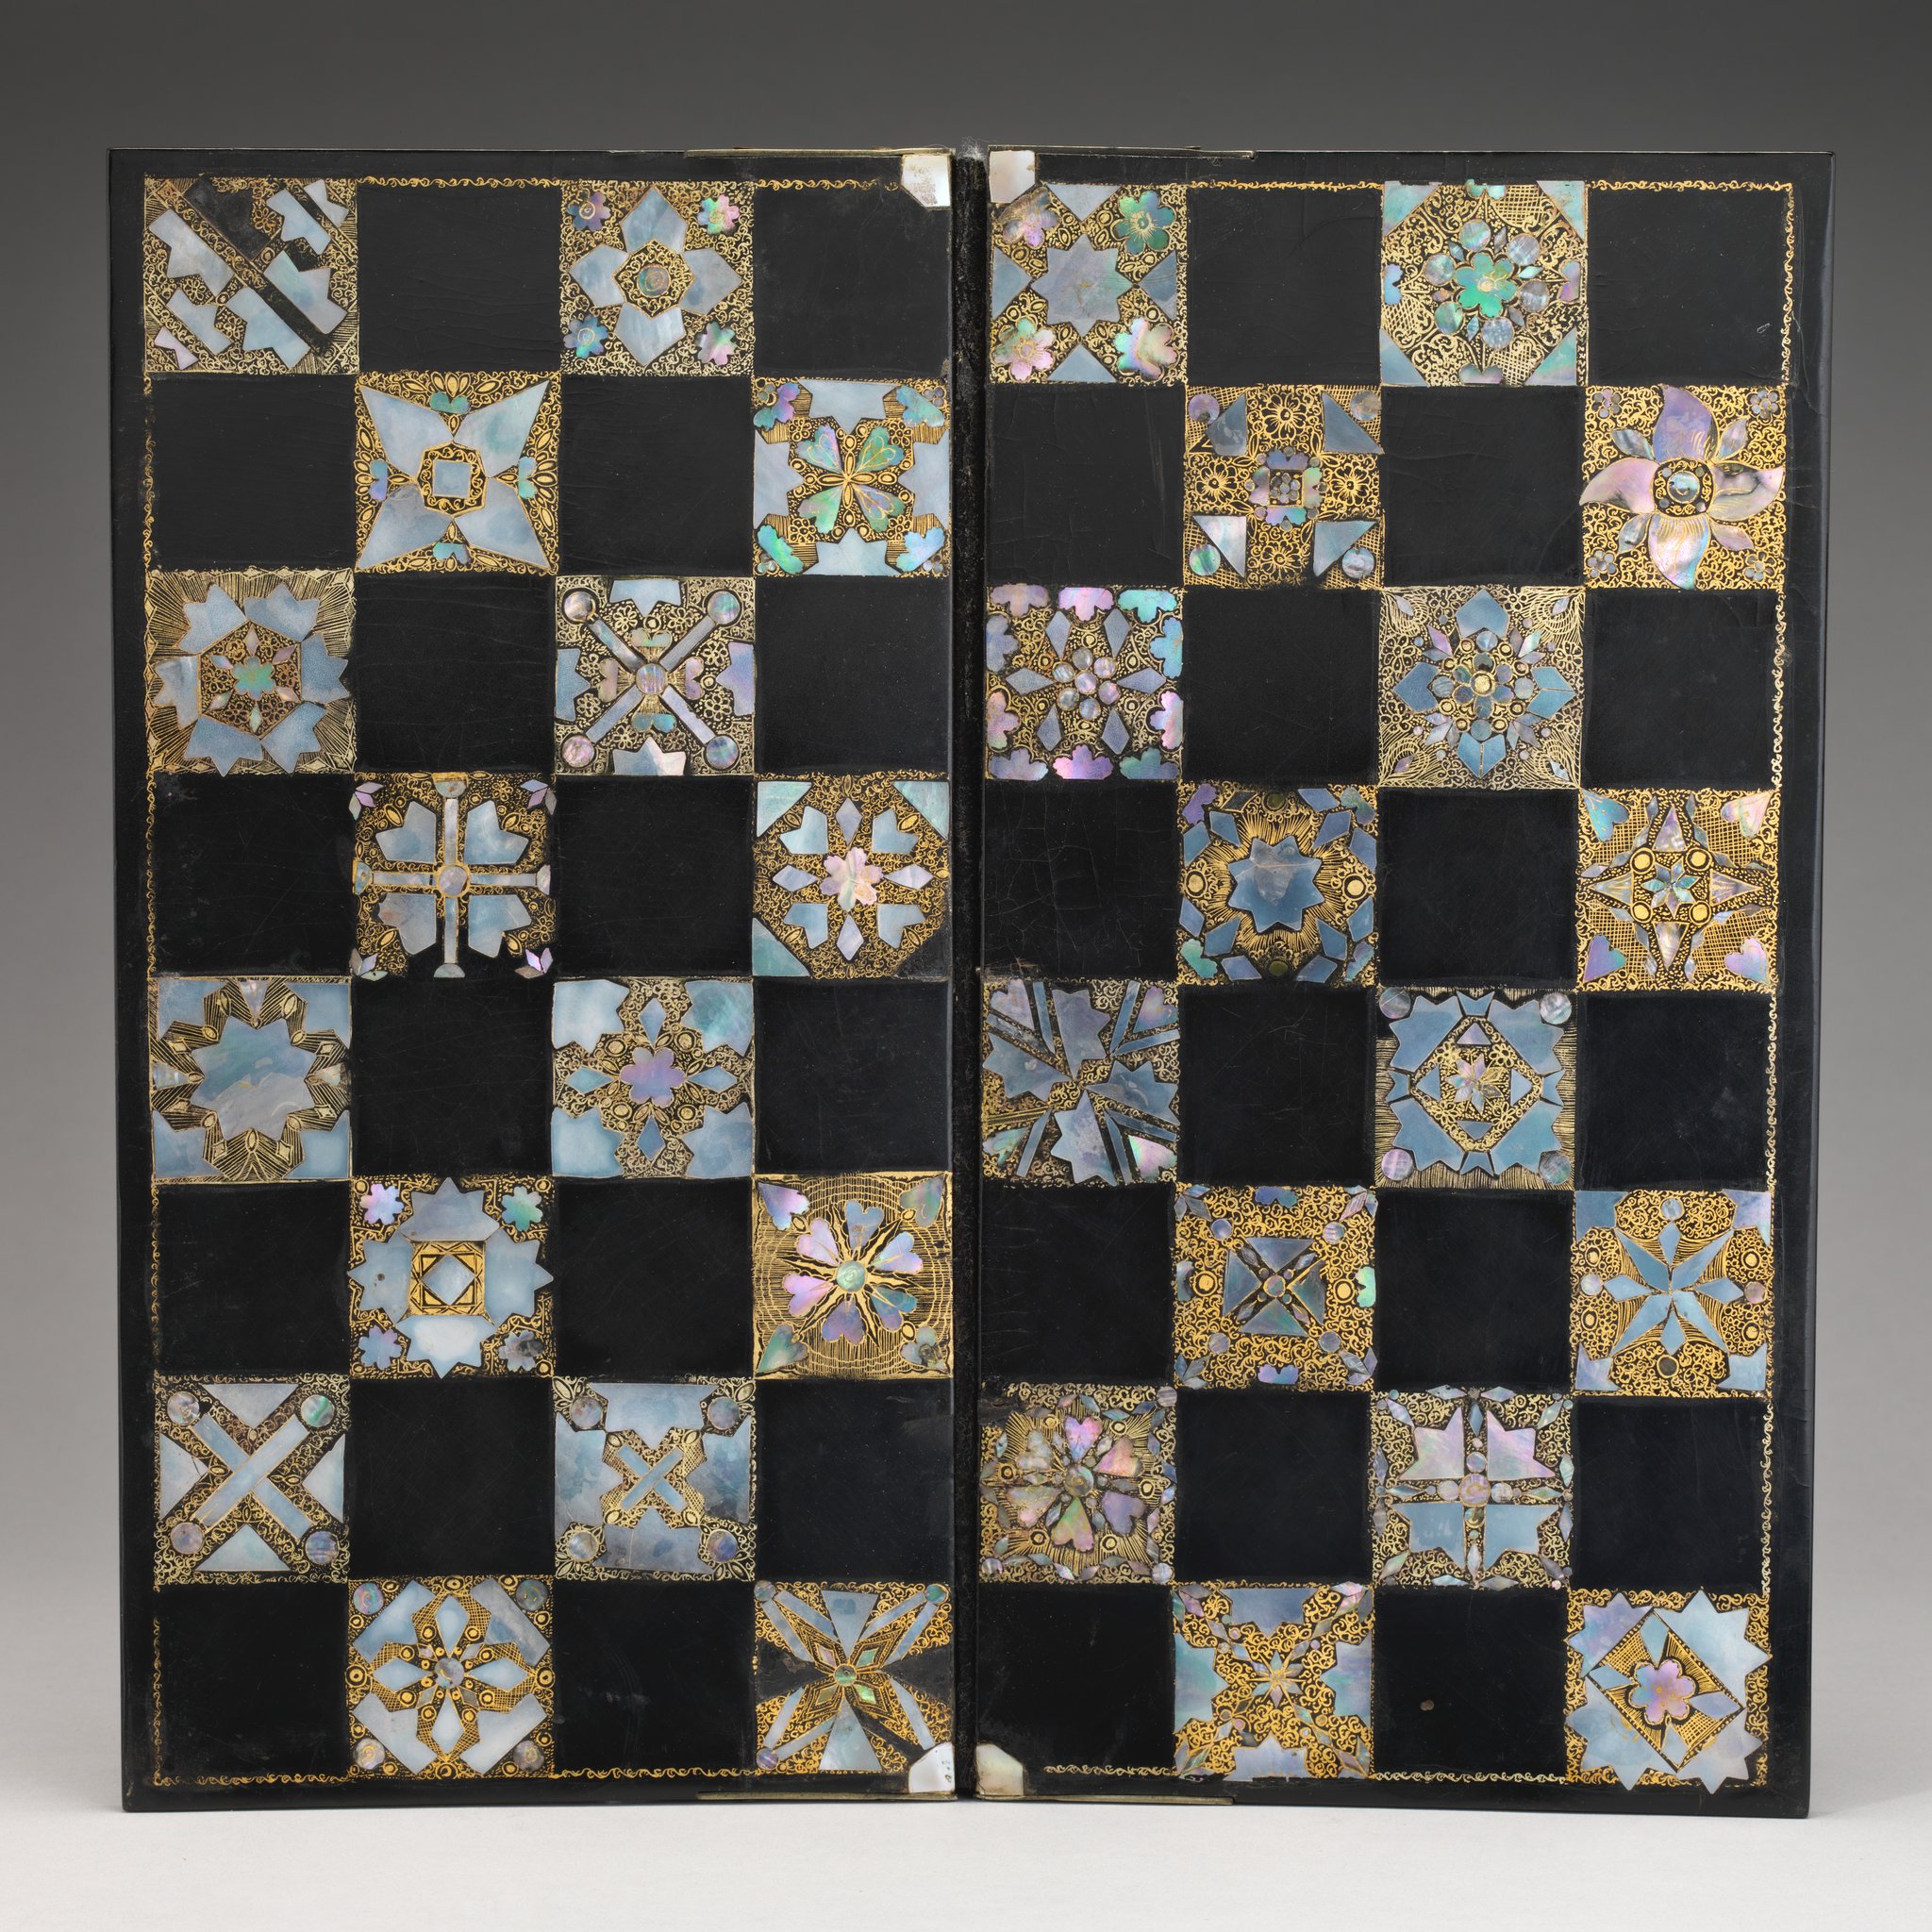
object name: chessboard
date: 1801-1900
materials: lacquer, mother of pearl, paper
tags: chess